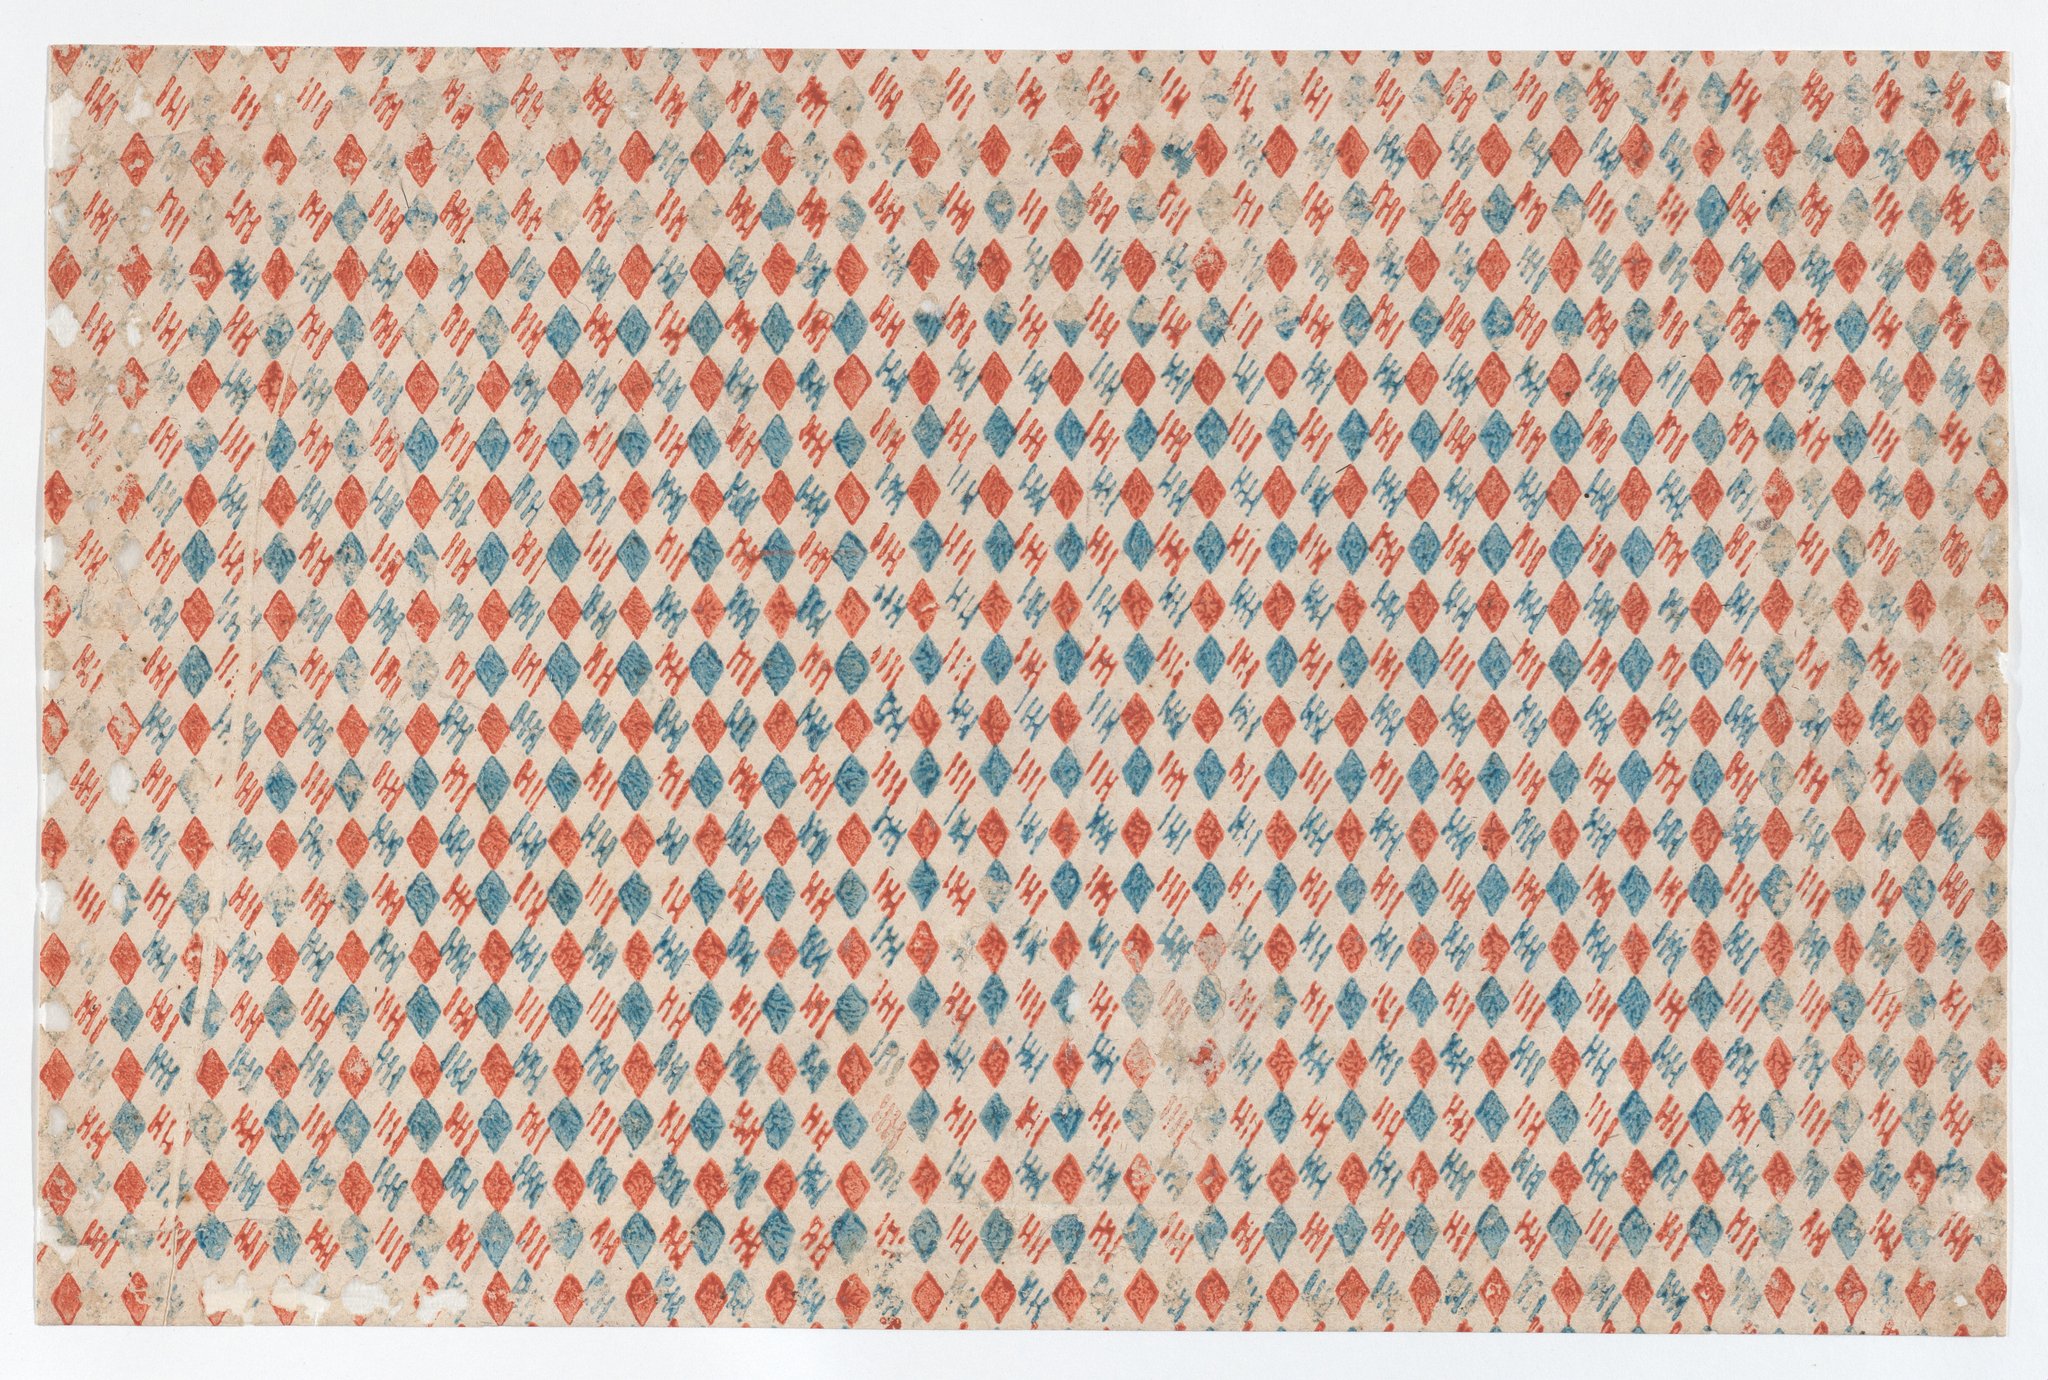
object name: print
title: Sheet with overall blue and red diamond pattern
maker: Anonymous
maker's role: artist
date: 1801-1900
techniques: relief print